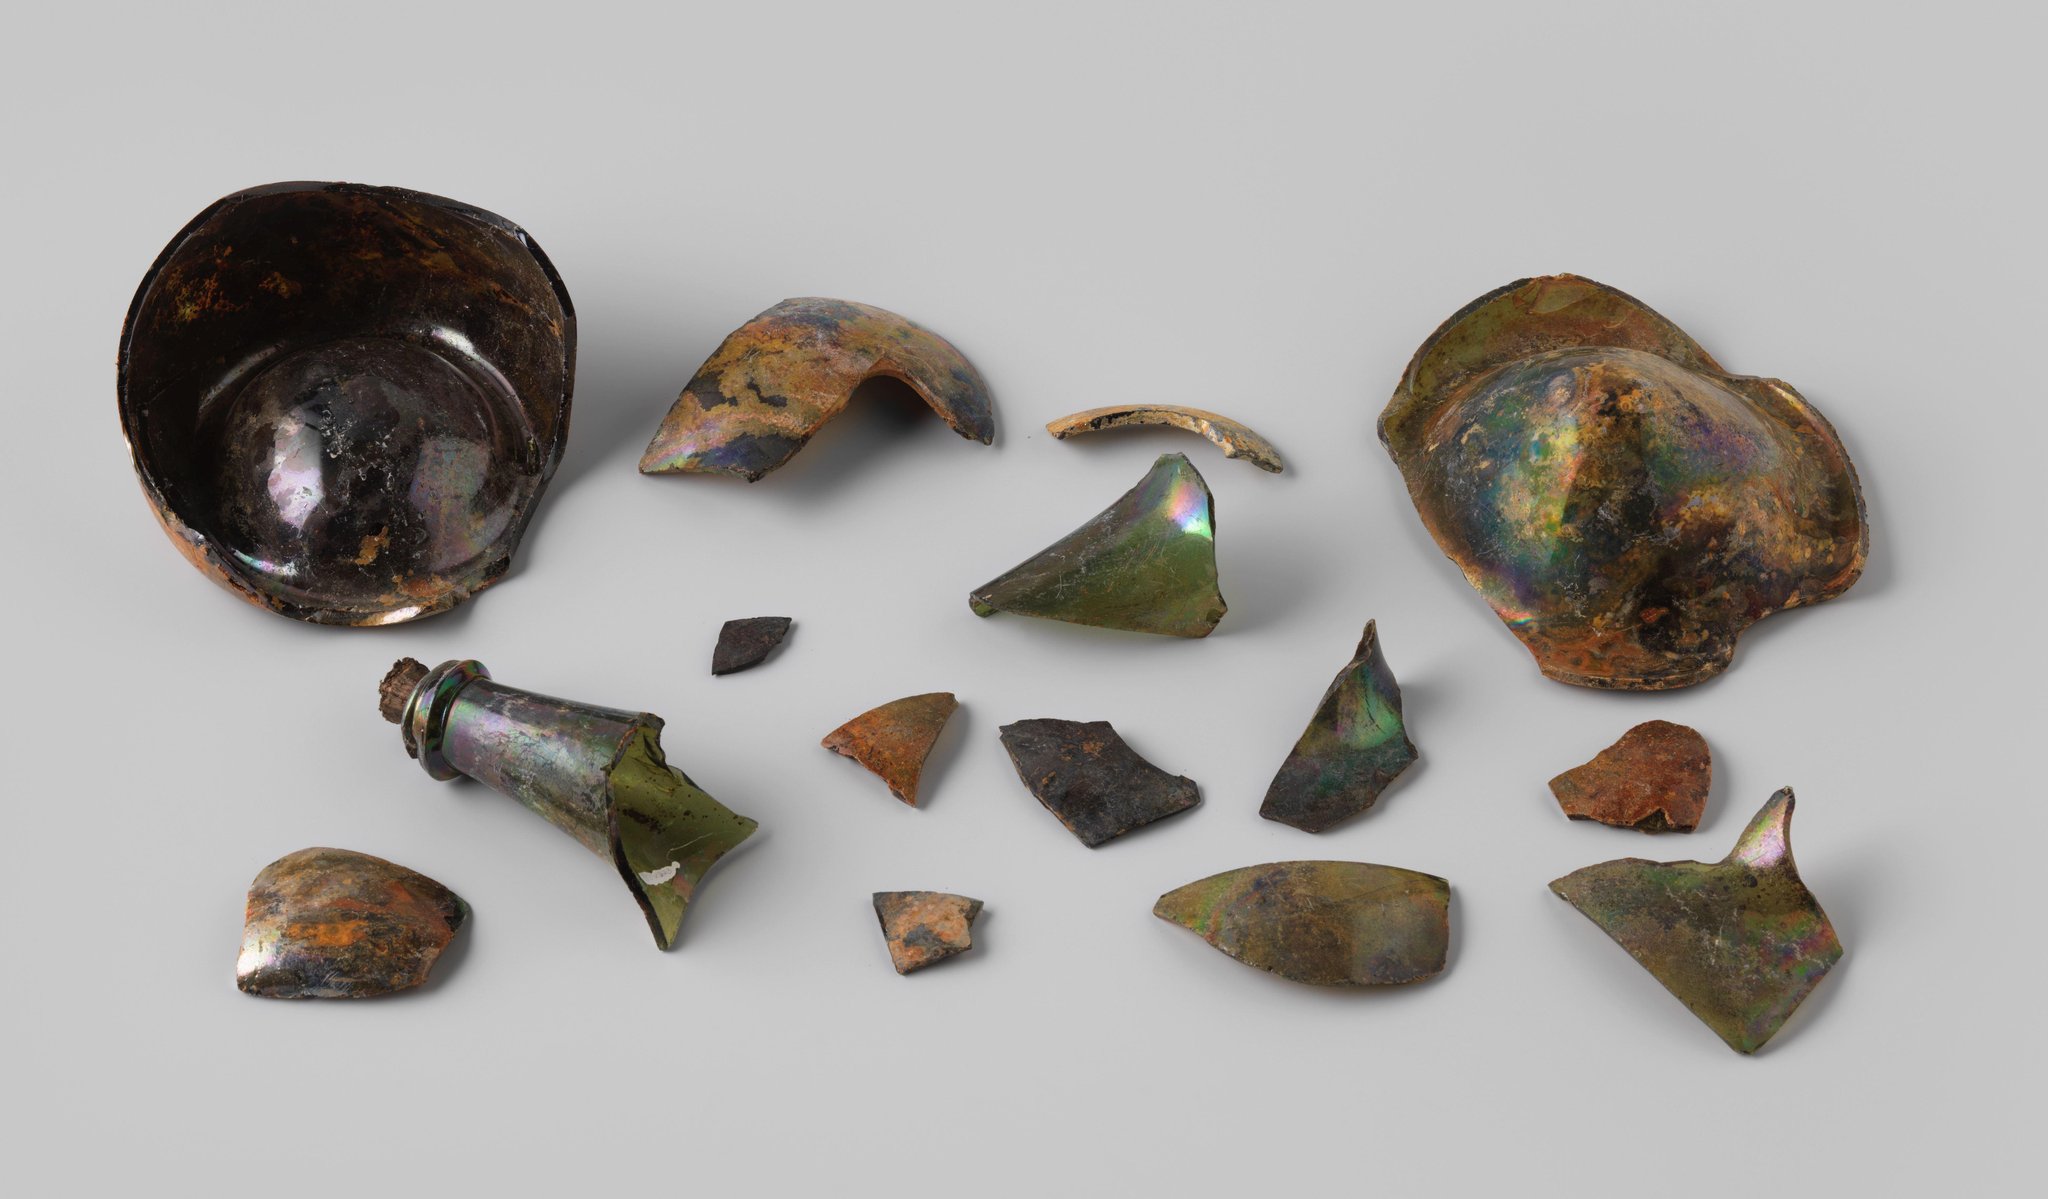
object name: wine bottle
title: Scherven van wijnflessen uit het wrak van de Oost-Indiëvaarder 't Vliegend Hart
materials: cork, glass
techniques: green glass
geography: netherlands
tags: 't vliegend hart (schip), verenigde oostindische compagnie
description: Scherven van uivormige wijnflessen van groen glas waar rode (port)wijn in heeft gezeten. Hals met kurk.